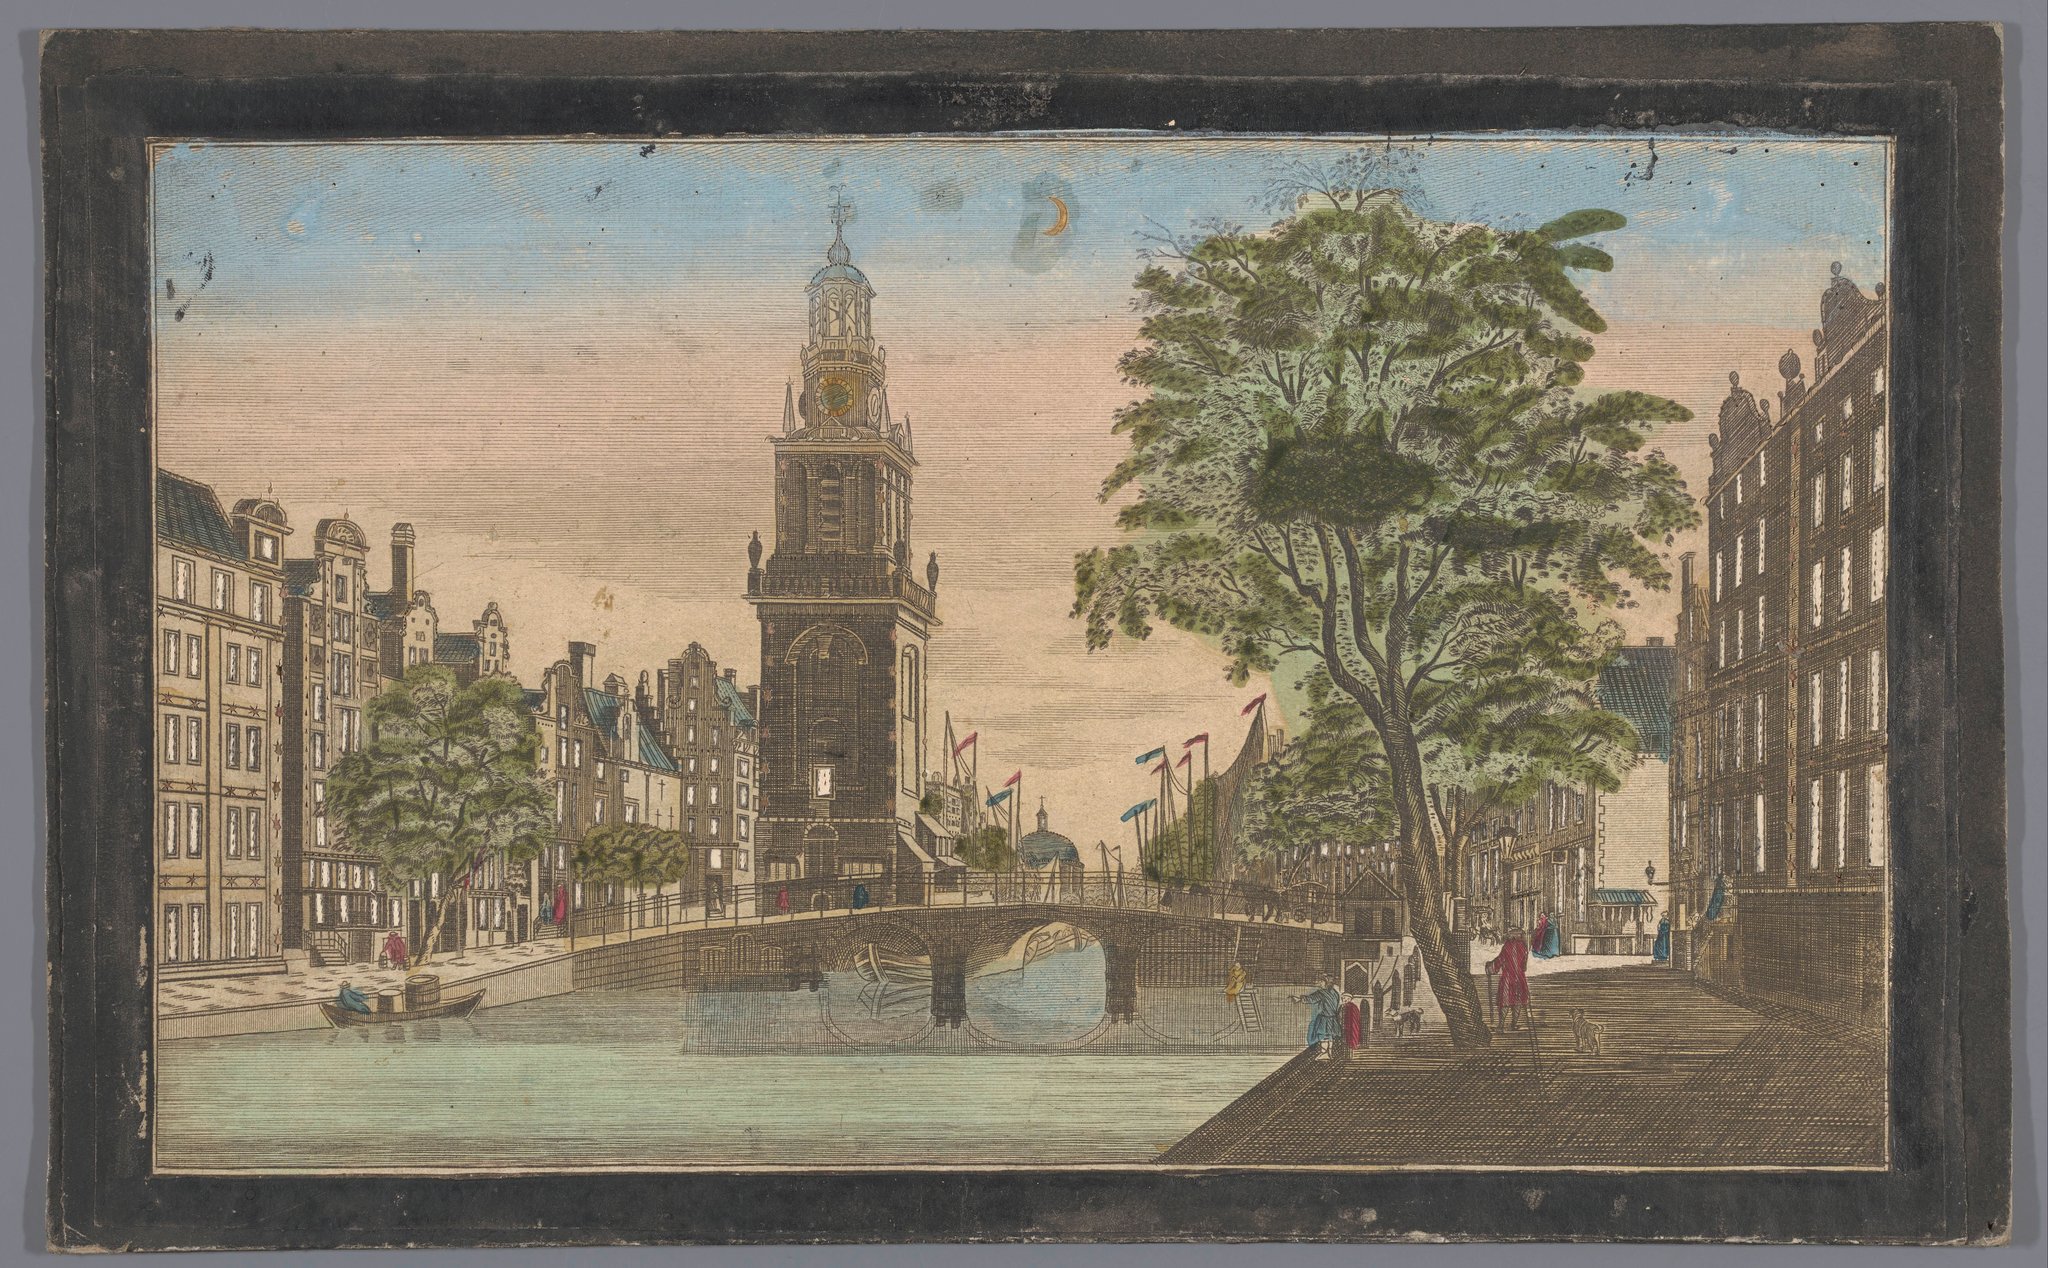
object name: print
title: Gezicht op de Jan Roodenpoortstoren te Amsterdam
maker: Anonymous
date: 1700-1799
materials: cardboard, paint, paper, watercolor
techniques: brush, cutting, etching, perforating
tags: bridge in city across river, canal, etc. (+ city(-scape) with figures, staffage), tower, clock tower ~ monumental adornment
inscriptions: collector's mark: Lugt 2233